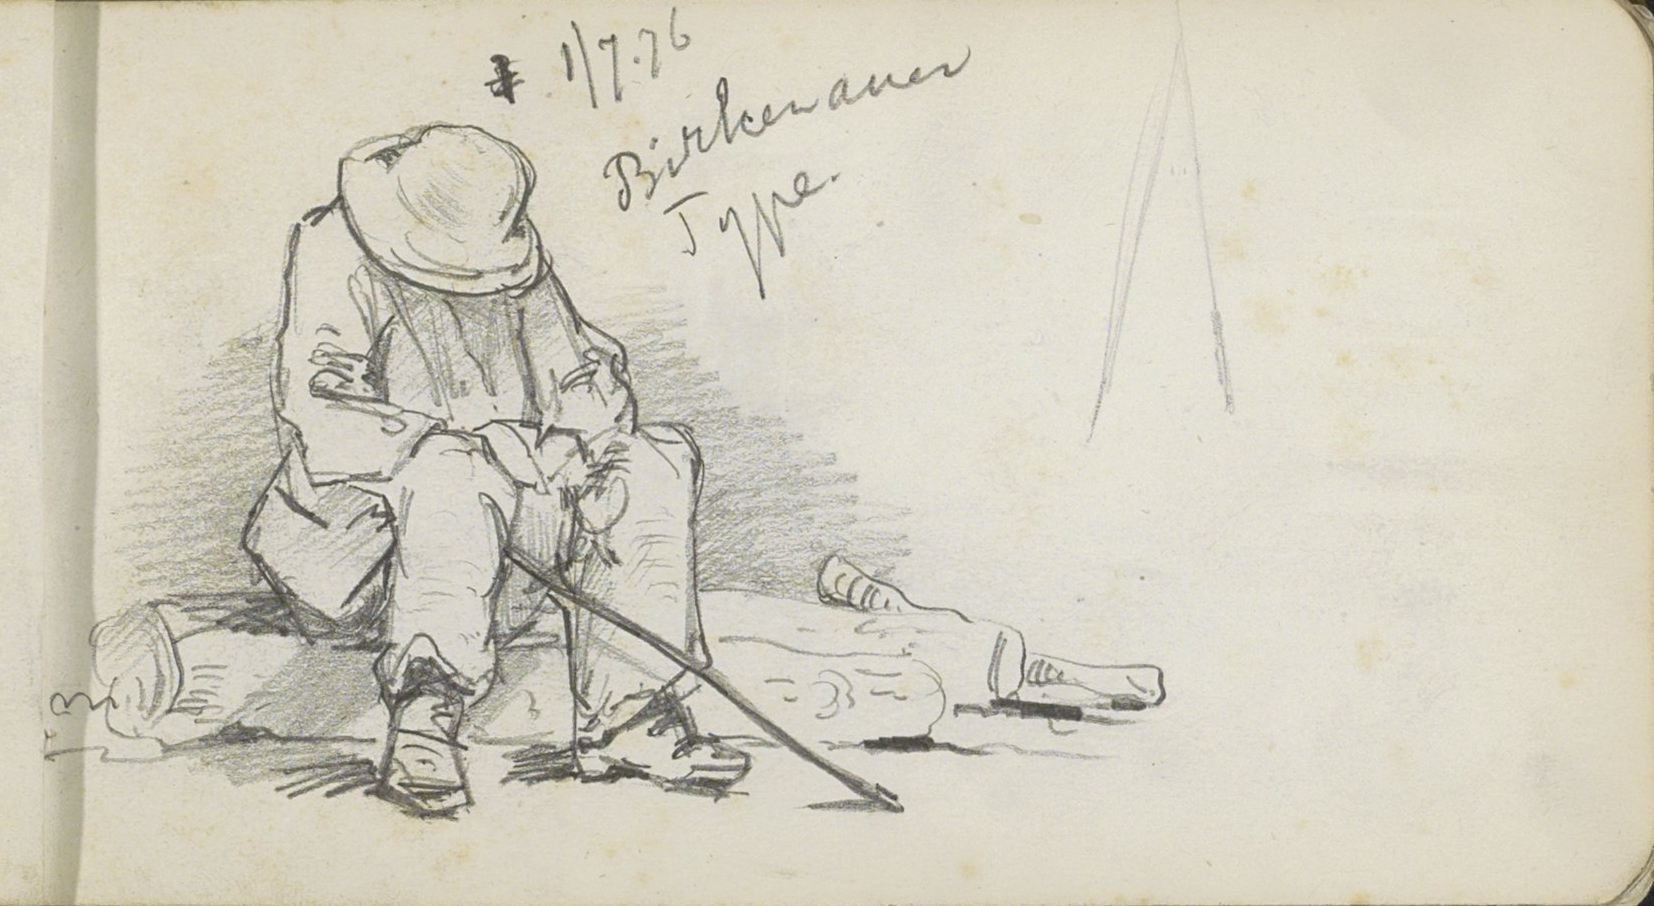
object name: sketchbook leaf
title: Zittende man met hoed uit Birkenau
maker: geo poggenbeek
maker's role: draughtsman, painter, print maker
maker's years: 1853-1903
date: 1807-1876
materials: paper, pencil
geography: birkenau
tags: sitting figure, walking-stick, staff, head-gear: hat (+ men's clothes)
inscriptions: date and inscription: ‘1/7.76/ Birkenauer/Type.’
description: De man zit op een boomstam met zijn wandelstok. Losse tekening tussen blad 12 en 13 uit een schetsboek met 69 bladen.